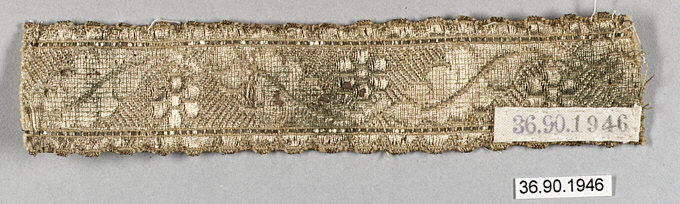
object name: galloon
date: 1701-1800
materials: silk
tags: flowers